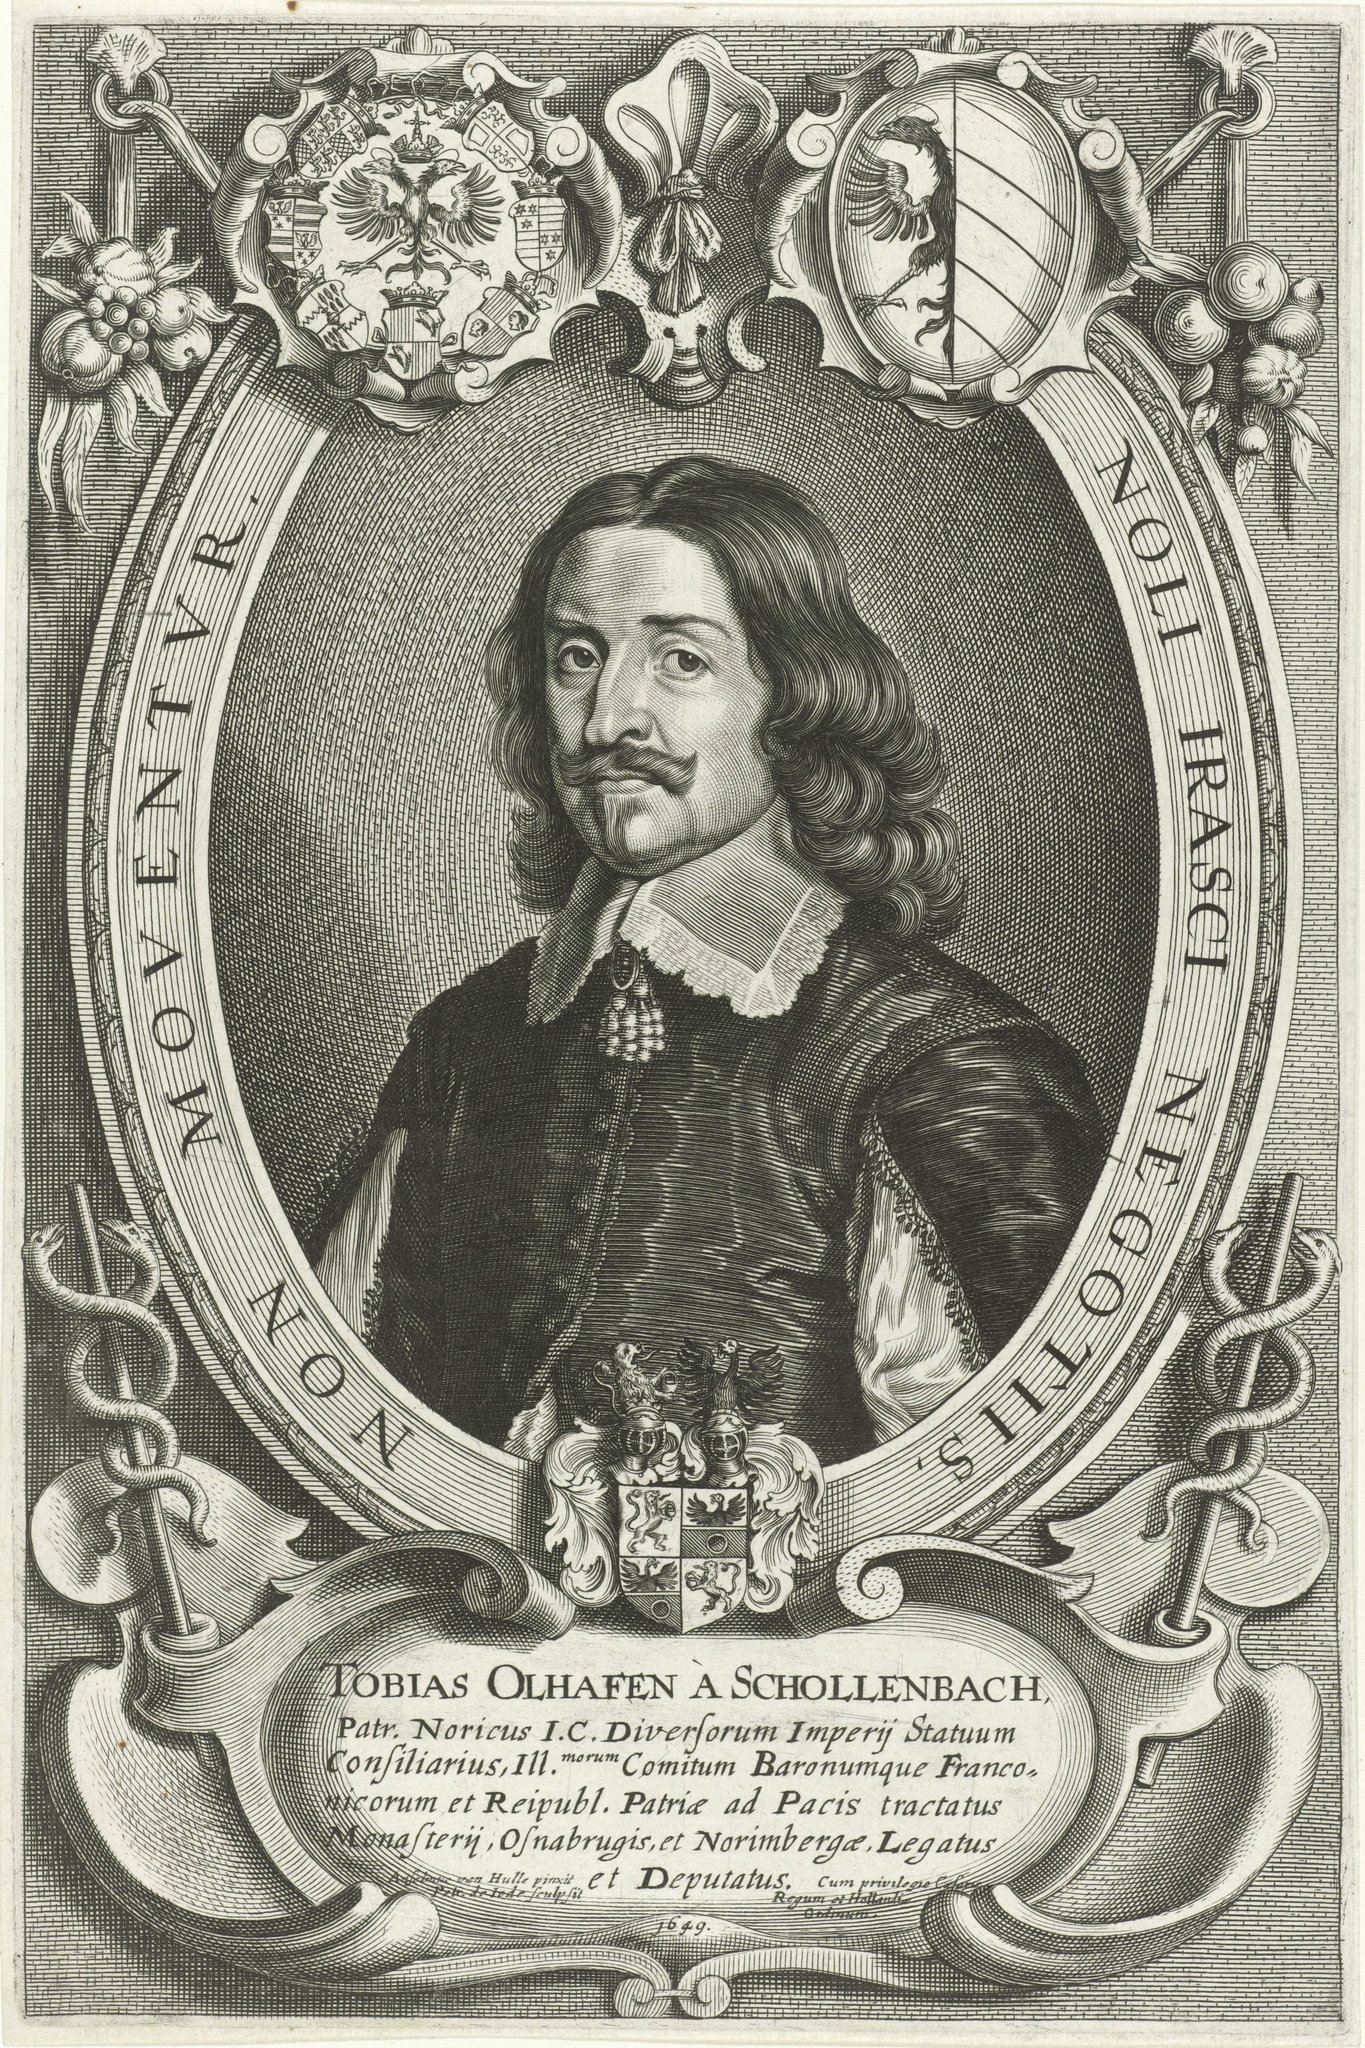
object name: print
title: Portret van Tobias Oelhafen van Schöllenbach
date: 1649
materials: paper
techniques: engraving, etching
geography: antwerp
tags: caduceus (staff with two snakes, attribute of mercury)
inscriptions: collector's mark: Lugt 2228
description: Busteportret van Tobias Oelhafen van Schöllenbach. Het portret is gevat in een ovale omlijsting met het wapenschild van de geportretteerde, decoraties en een randschrift in het Latijn. In de cartouche, geflankeerd door twee caduceus, een zesregelig onderschrift in het Latijn. Prent uit een serie portretten naar schilderijen van Anselmus van Hulle van alle gedelegeerden bij de vredesonderhandelingen te Münster en Osnabrück.